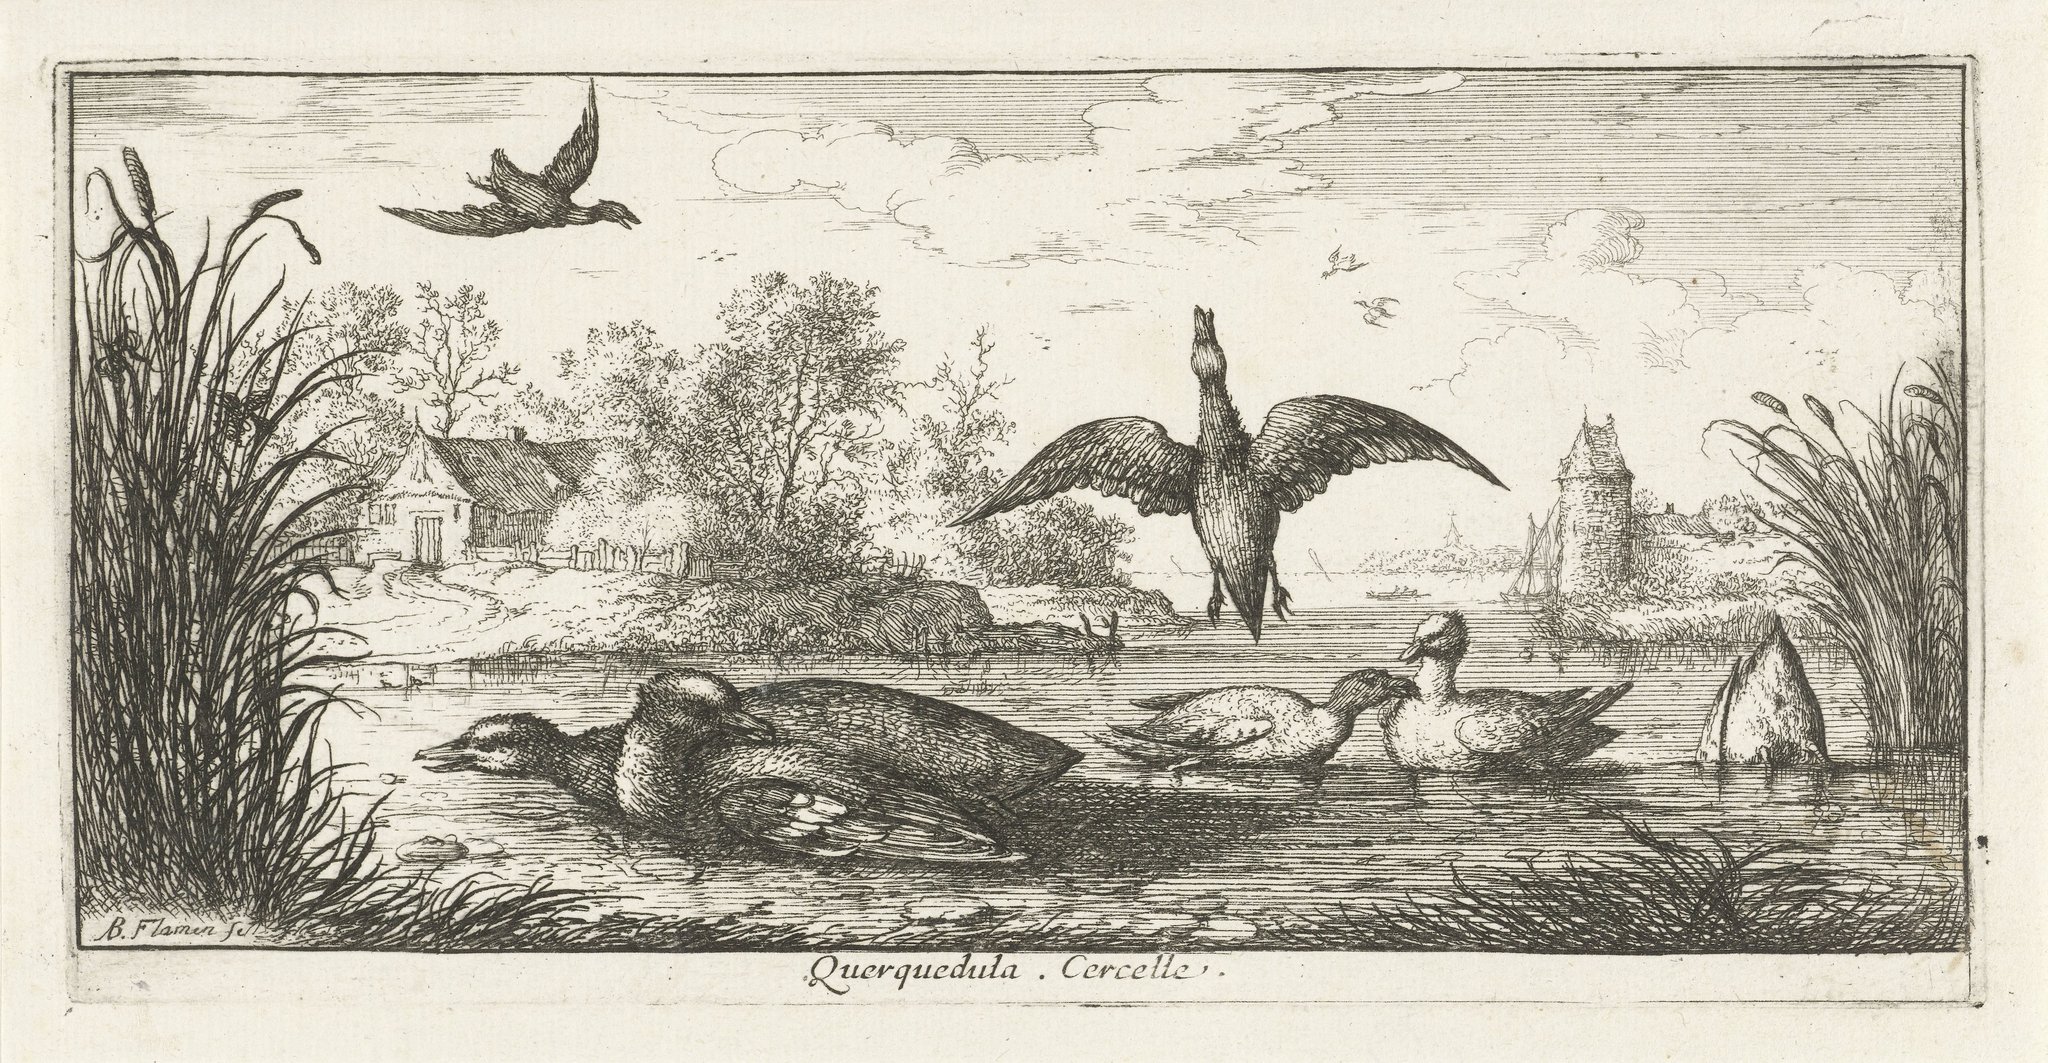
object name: print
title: Livre d'oyseavx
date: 1648-1692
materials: paper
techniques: etching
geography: paris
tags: water-birds: duck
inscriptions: collector's mark: Lugt 240